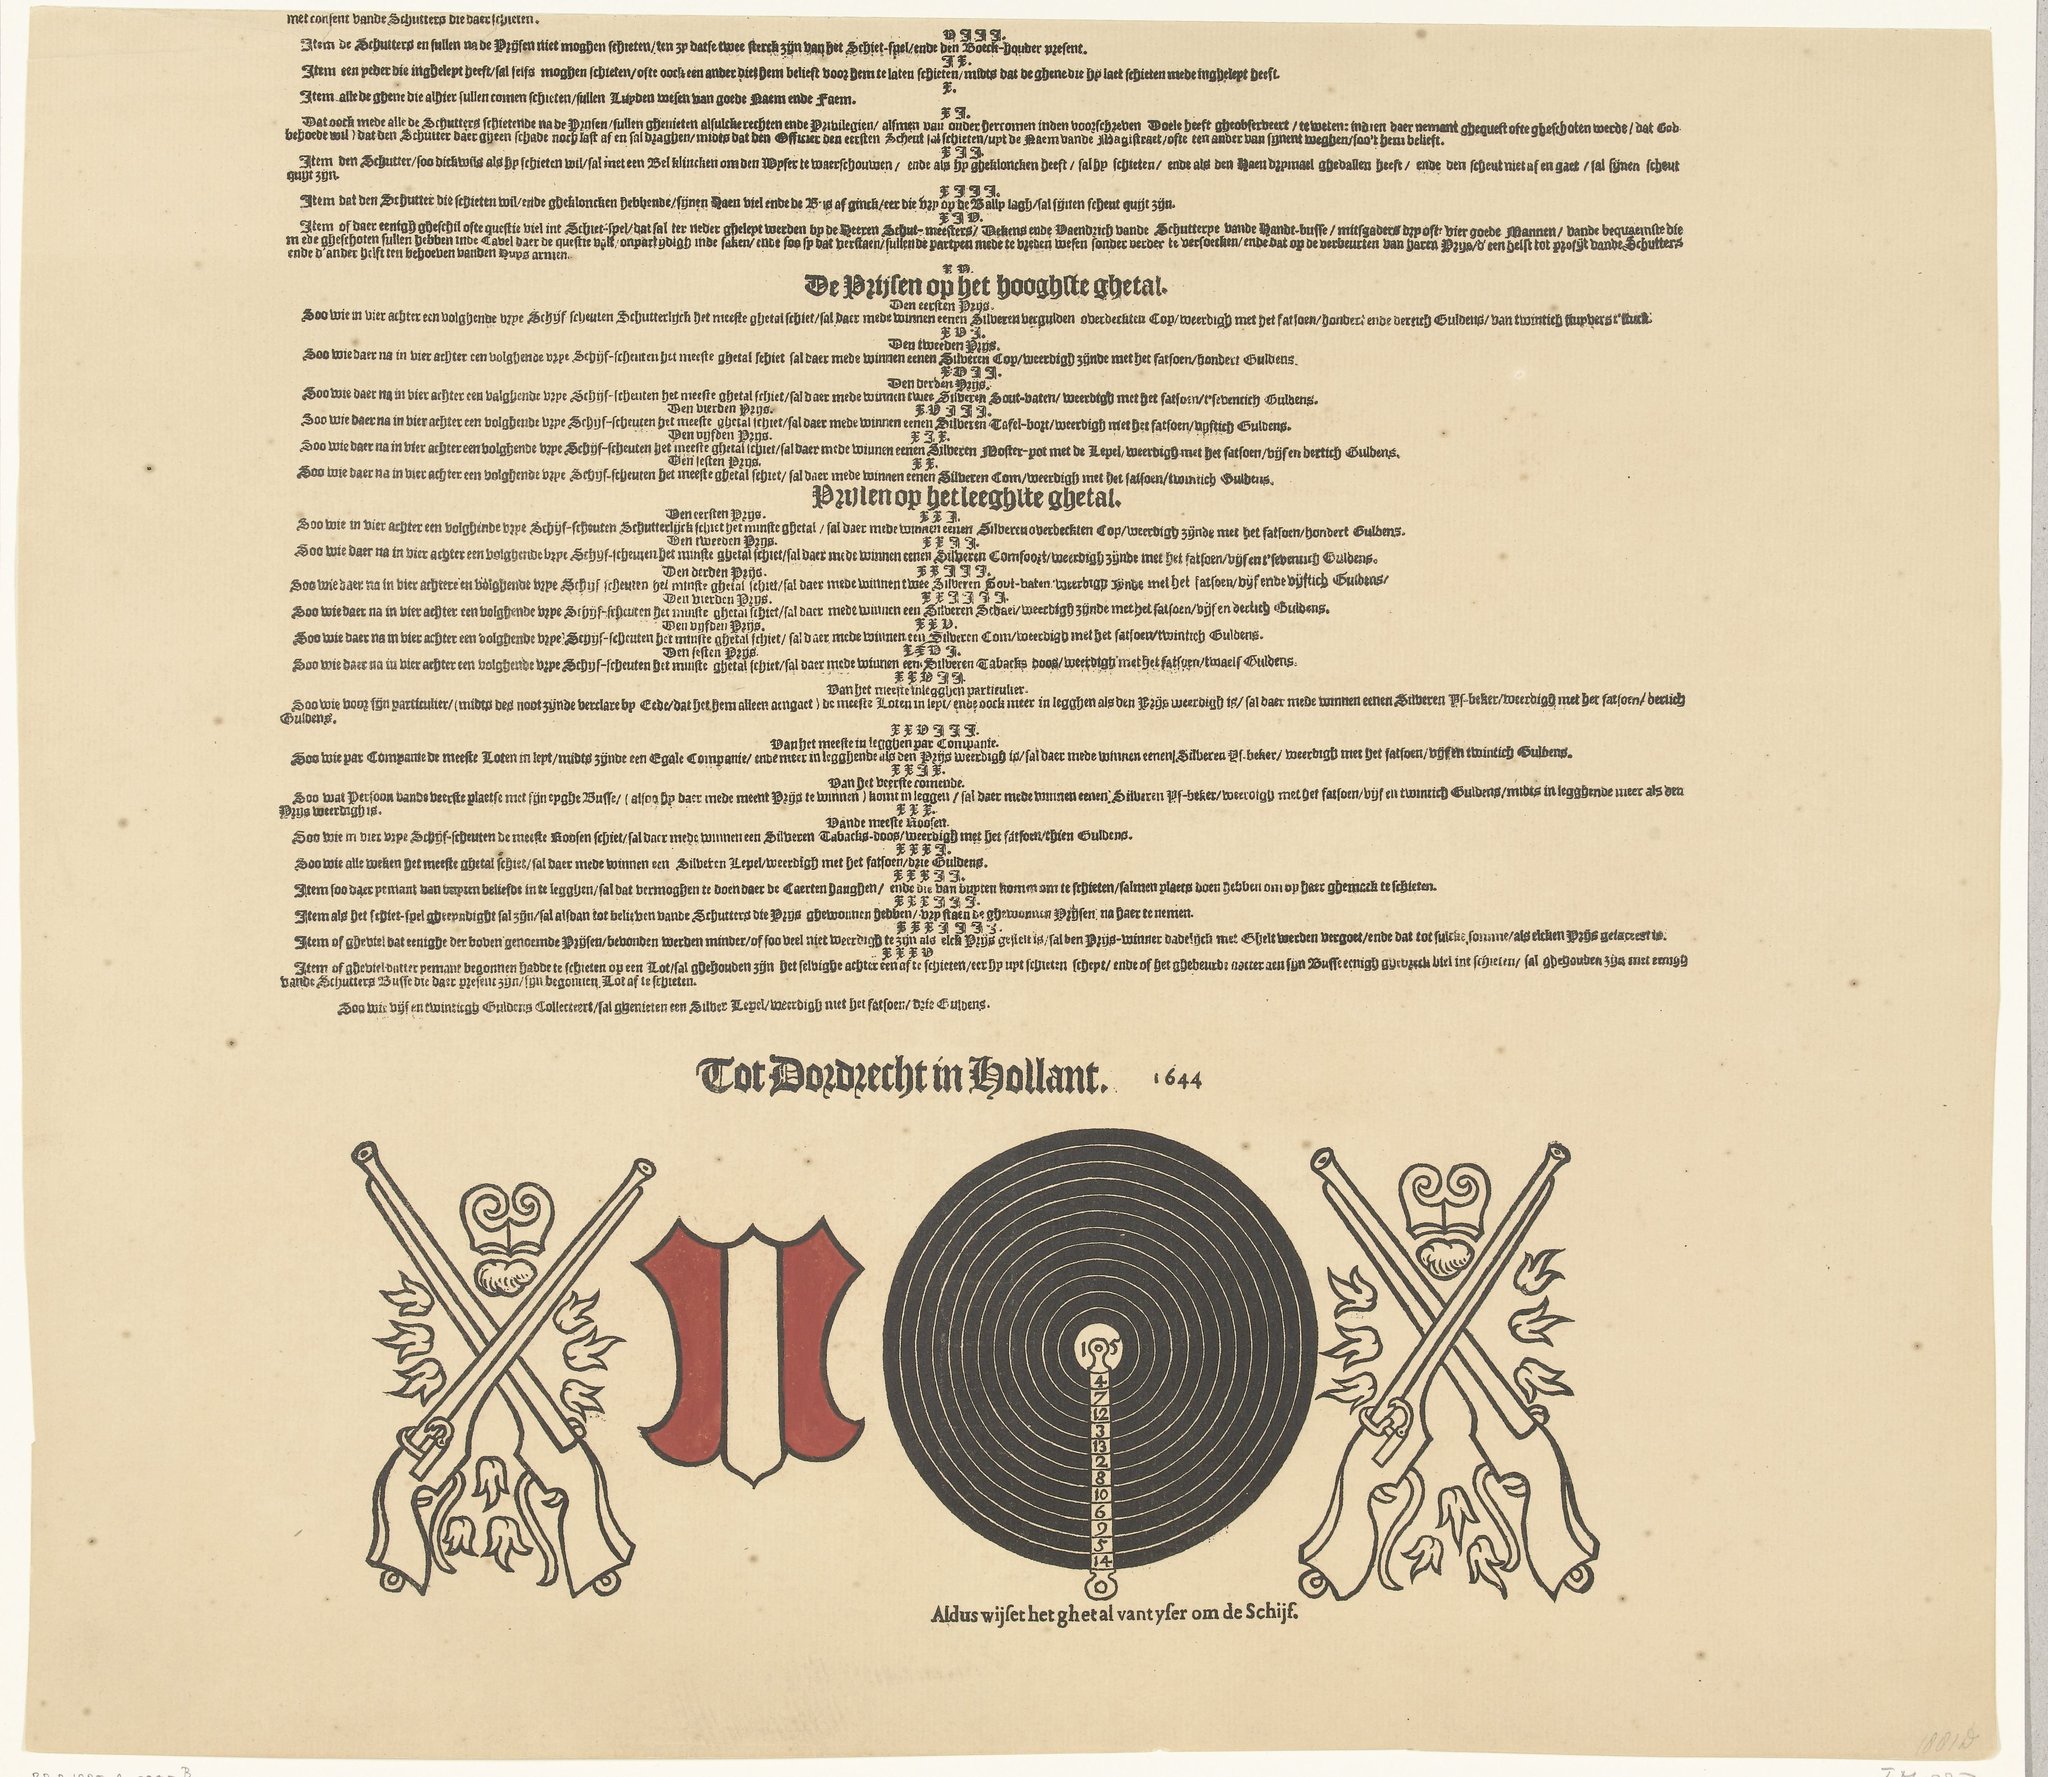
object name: loterijprent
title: Oproep tot het inschrijven voor een schietwedstrijd en loterij in de Kloveniersdoelen te Dordrecht in 1644 (onderste helft)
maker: Anonymous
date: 1800-1885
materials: paper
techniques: printing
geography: netherlands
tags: sharpshooting with revolver or other handgun (~ games of skill), dordrecht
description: Oproep tot het inschrijven voor een schietwedstrijd met de handbus en loterij in de Kloveniersdoelen te Dordrecht, te houden tussen 22 augustus en 15 oktober 1644. Tweede deel van het reglement van de wedstrijd met onderaan een schietschijf, het wapen van Dordrecht en twee gekruiste handbussen in de hoeken. Onderste helft van een negentiende-eeuwse reproductie naar het originele biljet.